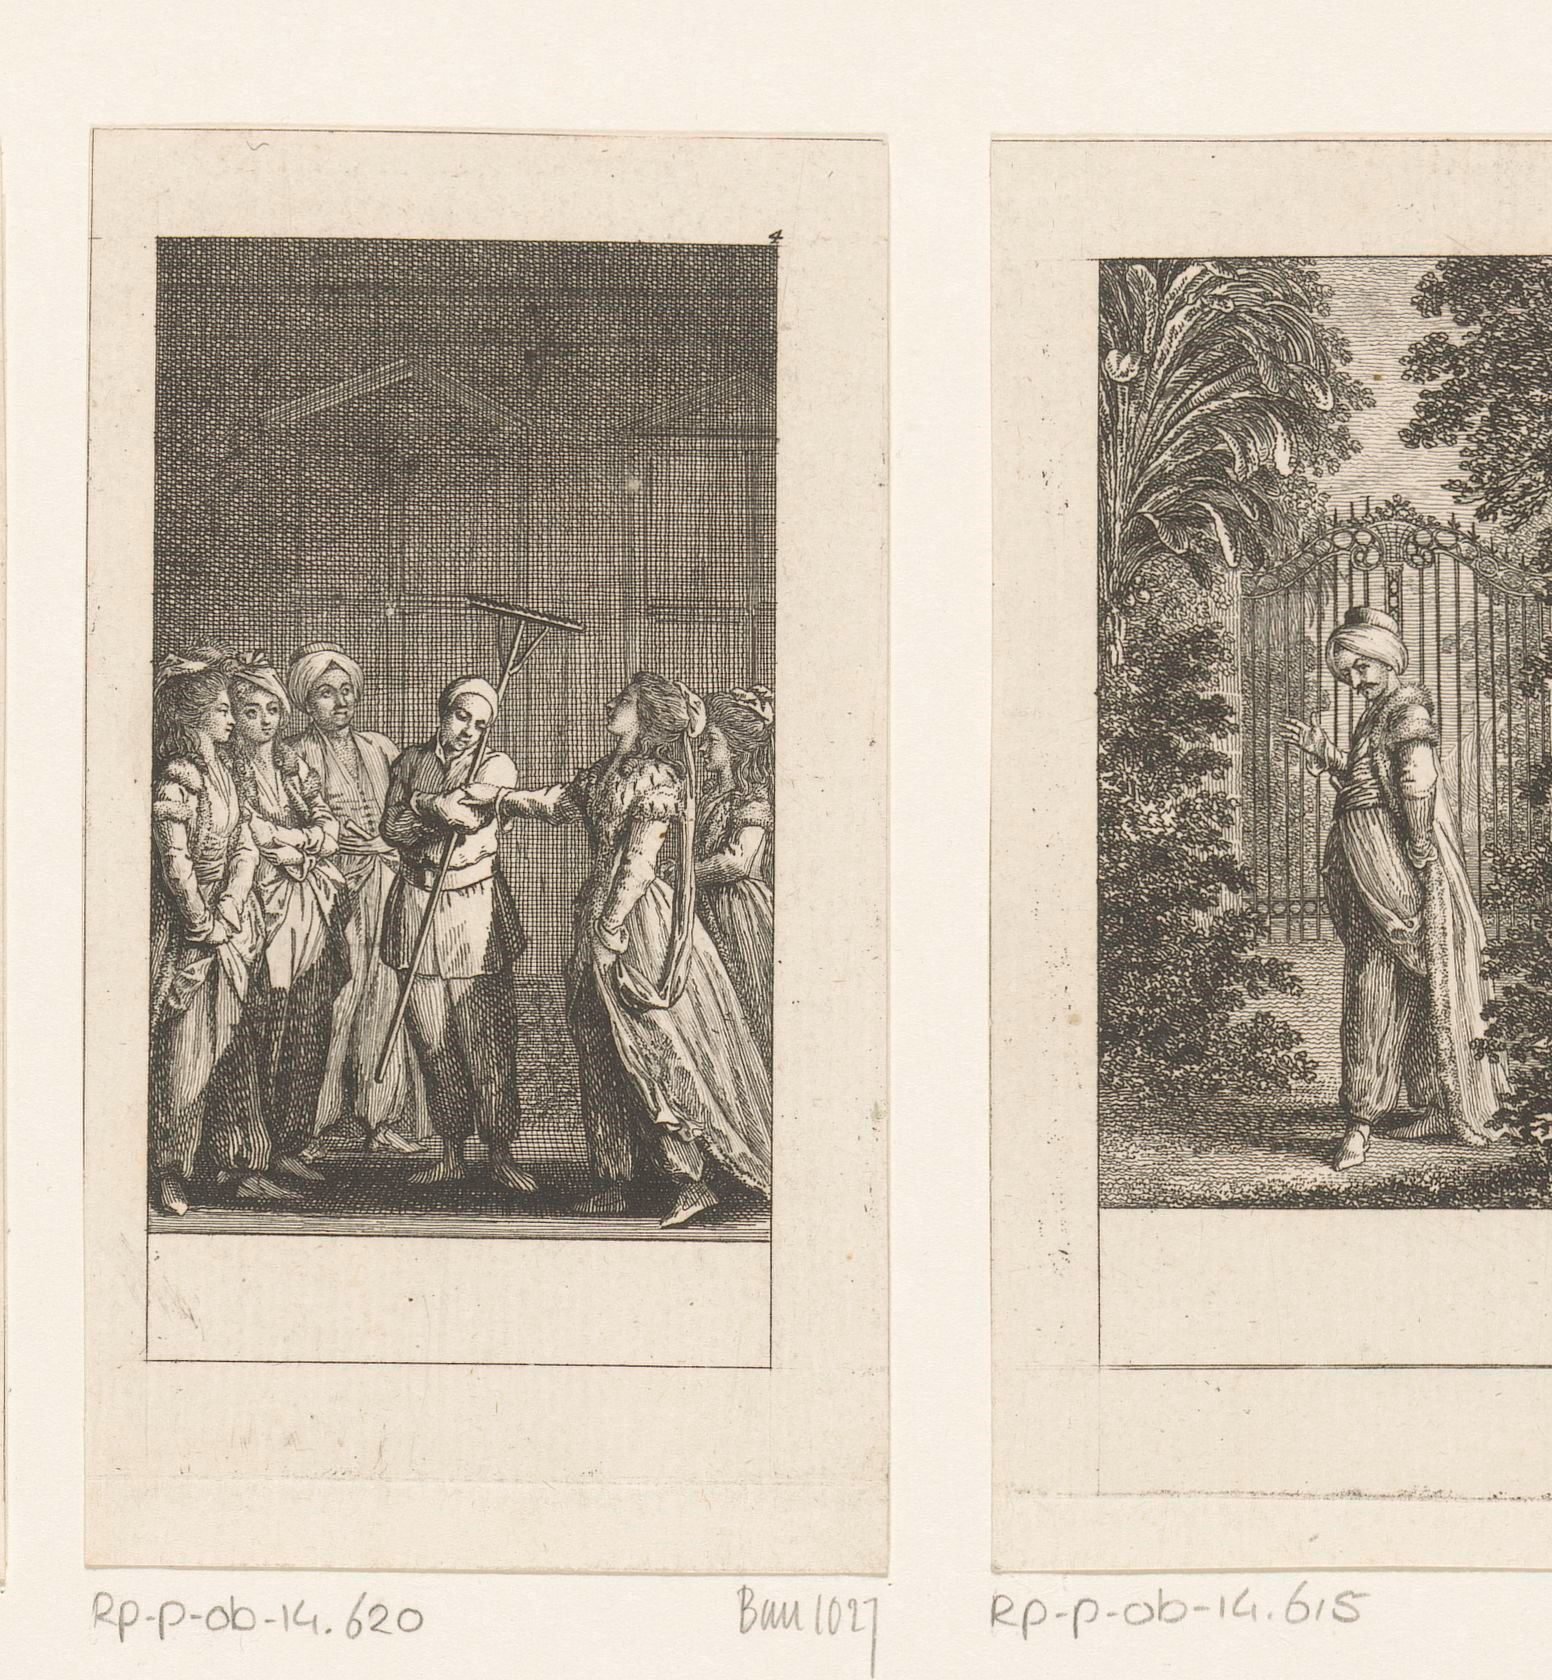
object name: print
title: Velaska vraagt Karl of hij iemand liefheeft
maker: daniel nikolaus chodowiecki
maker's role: draughtsman, print maker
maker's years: 1726-1801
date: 1783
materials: paper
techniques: etching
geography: berlin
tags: berlin, literature, interior of the house, eunuch, conversation, dialogue; conversation piece, harem, agricultural implements: rake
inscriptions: collector's mark: Lugt 2228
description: Vervaardigd voor G. F. W. Grossmann's 'Adelheid von Veltheim'. Een latere staat gebruikt in: Königlich Grosbritannischer genealogischer Kalender auf das Jahr 1784. Lauenburg: Berenberg, 1783.